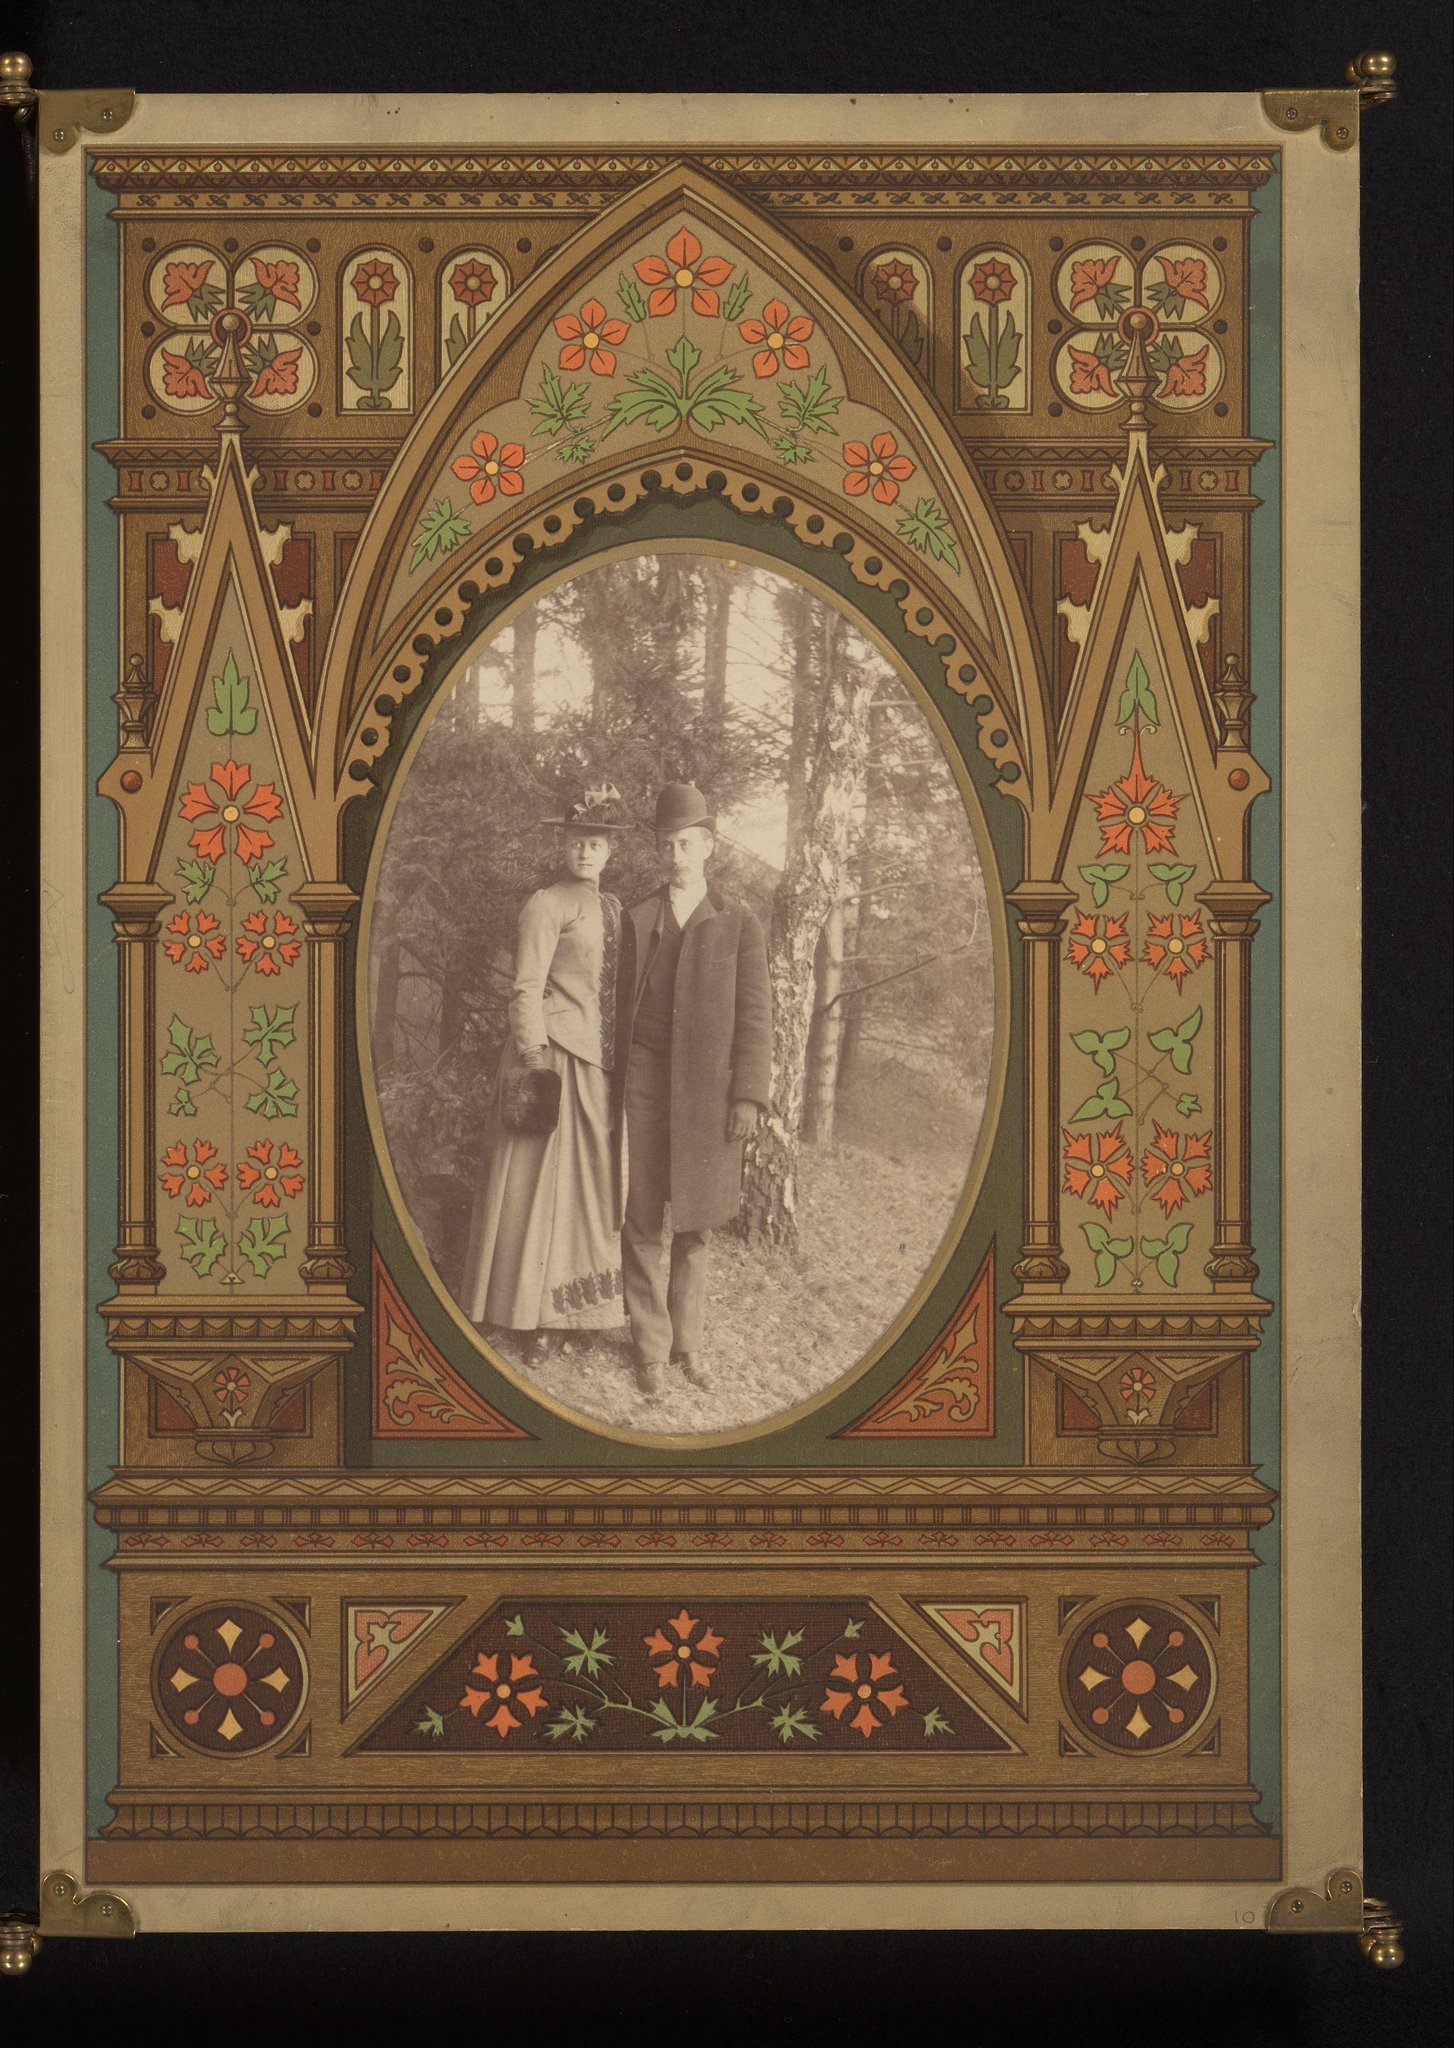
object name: album leaf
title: Portret van een man en een vrouw in een bos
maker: Anonymous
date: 1850-1900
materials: cardboard, photographic support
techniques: albumen print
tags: historical persons - bb - woman, historical persons, forest, wood